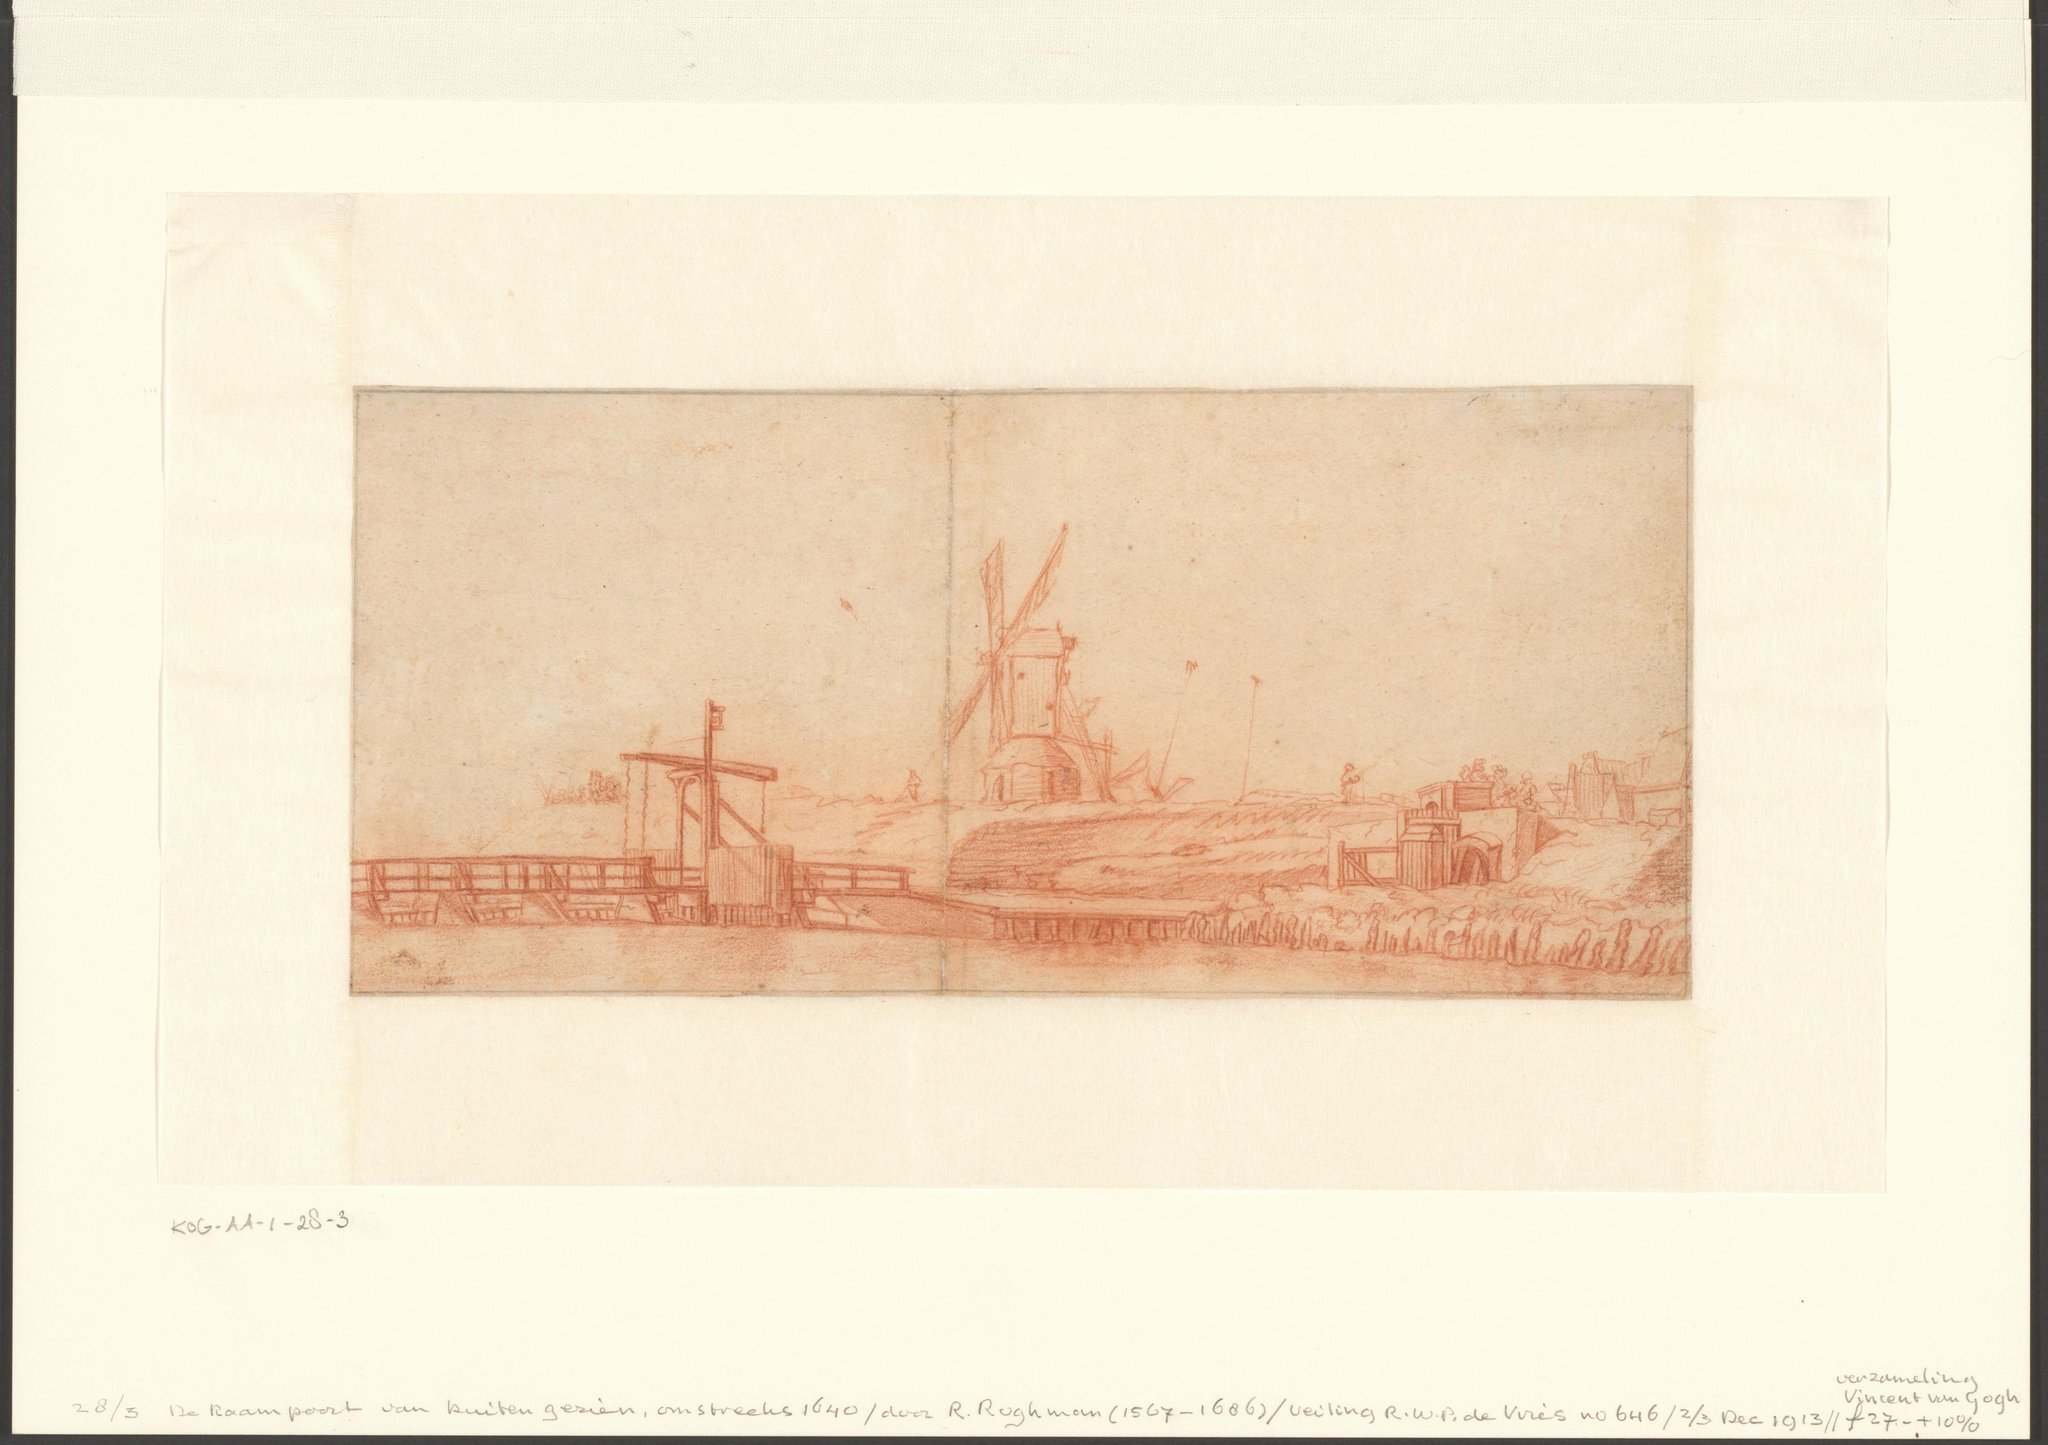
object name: drawing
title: Gezicht op de Raampoort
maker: roelant roghman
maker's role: draughtsman, painter, print maker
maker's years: 1627-1692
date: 1637-1692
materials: chalk, paper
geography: amsterdam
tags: city-view in general; 'veduta', windmill in landscape, city-gate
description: Onderwerpsrubriek binnen de Atlas Amsterdam: Raampoort.